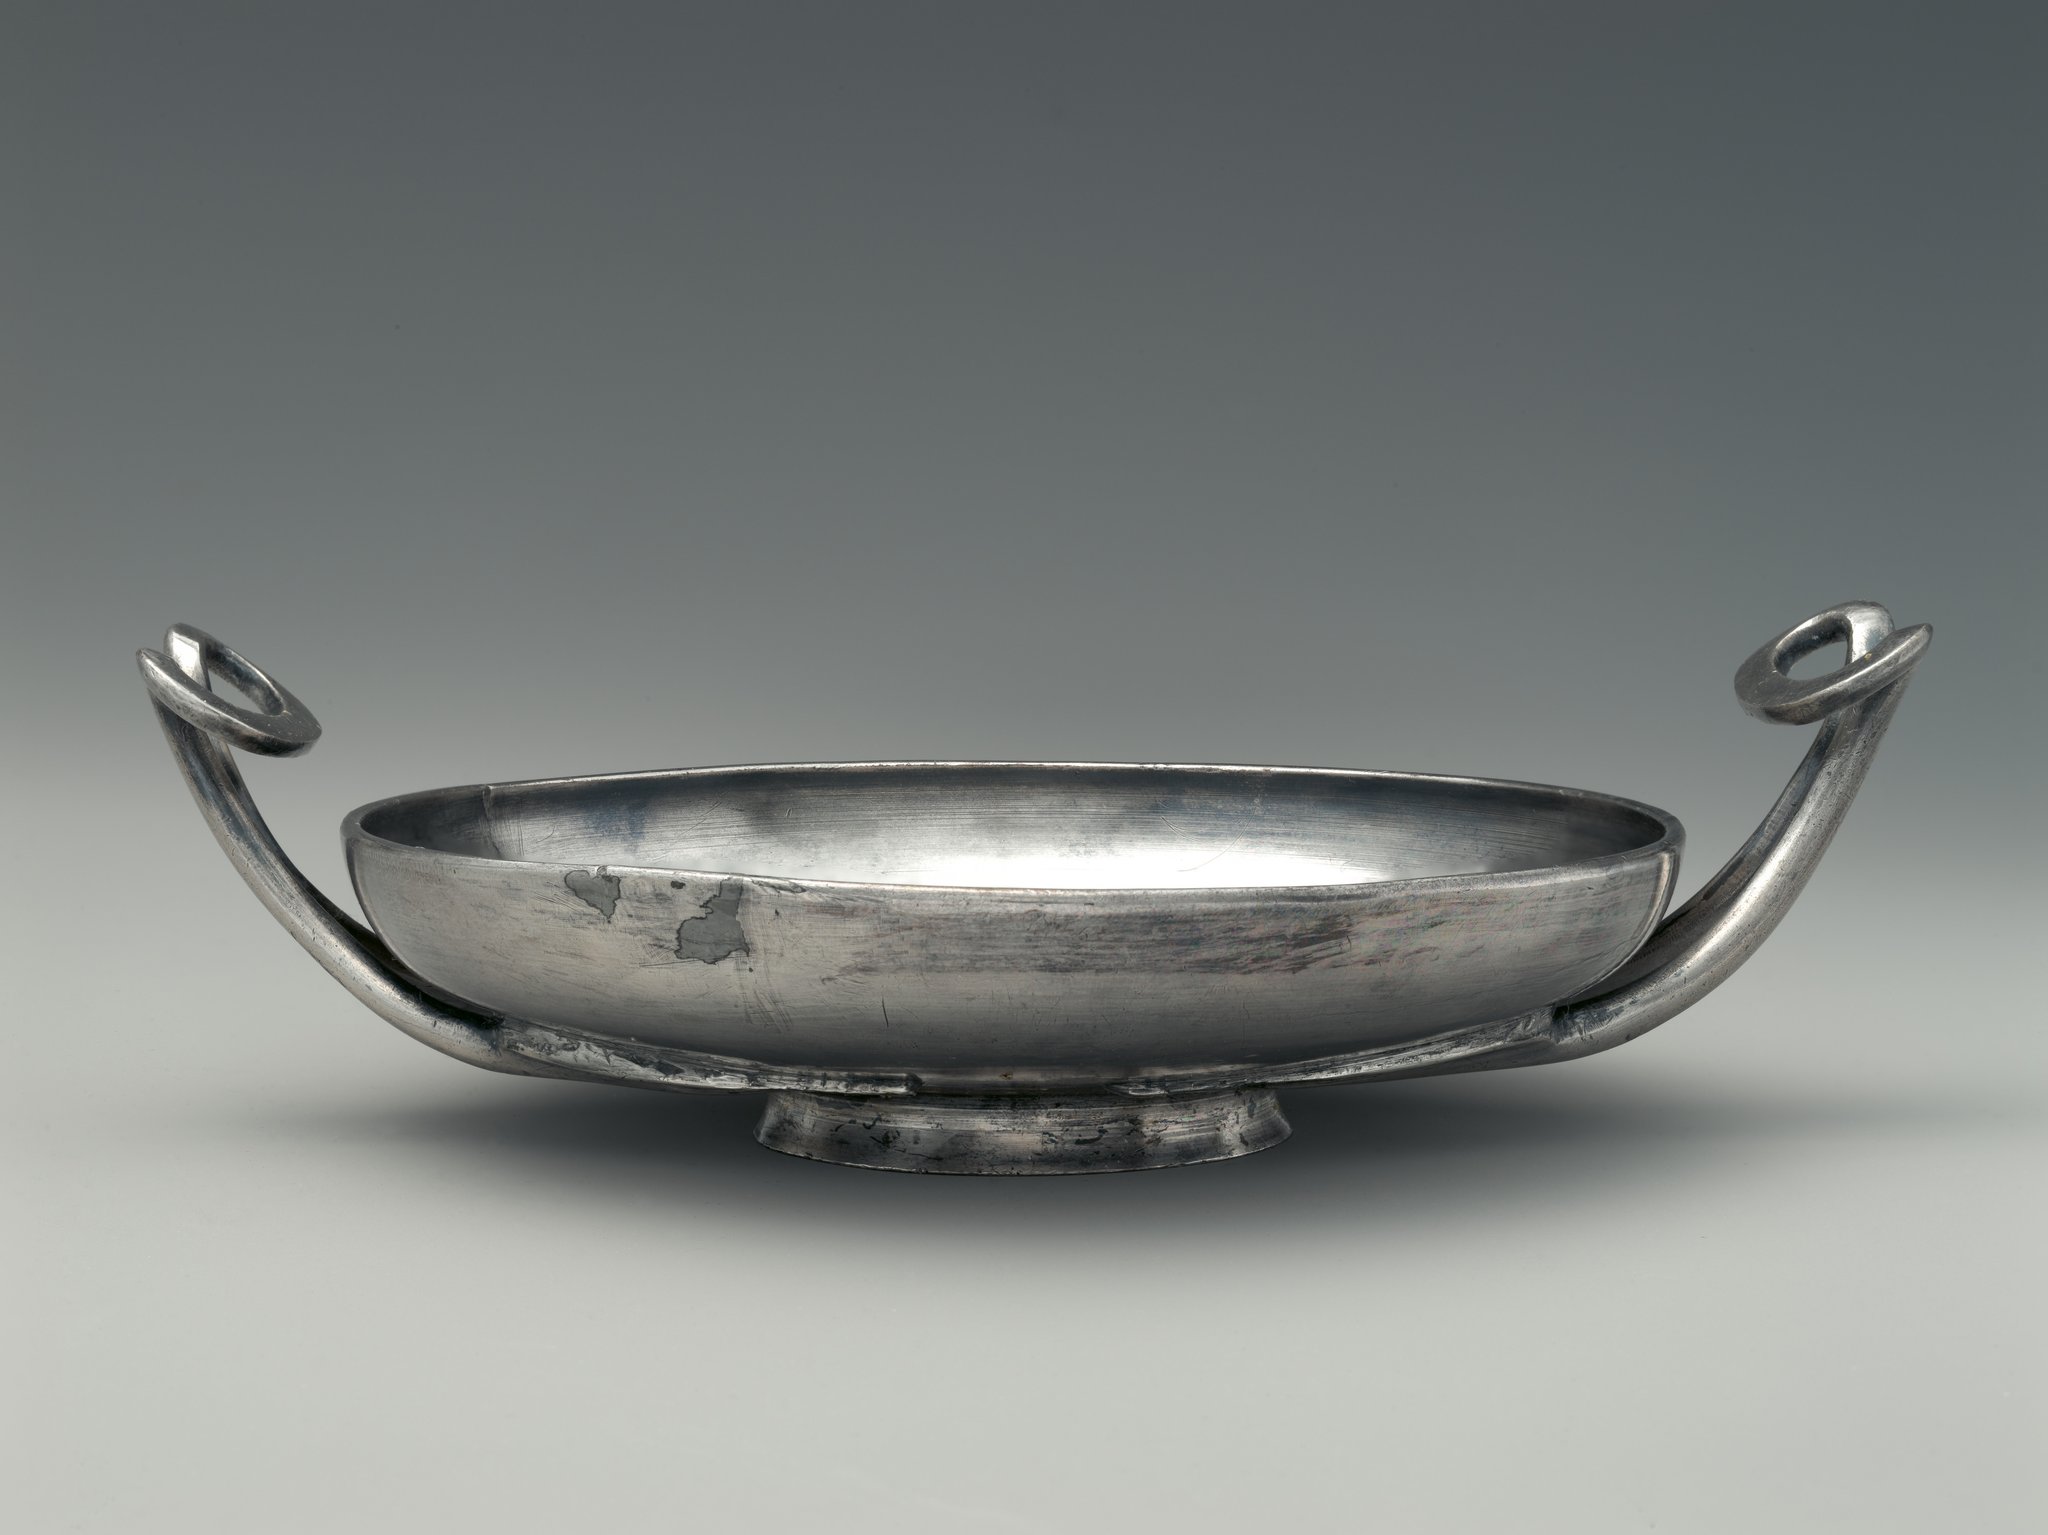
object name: kylix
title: Silver stemless cup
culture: greek or south italian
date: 334-301 BCE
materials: silver